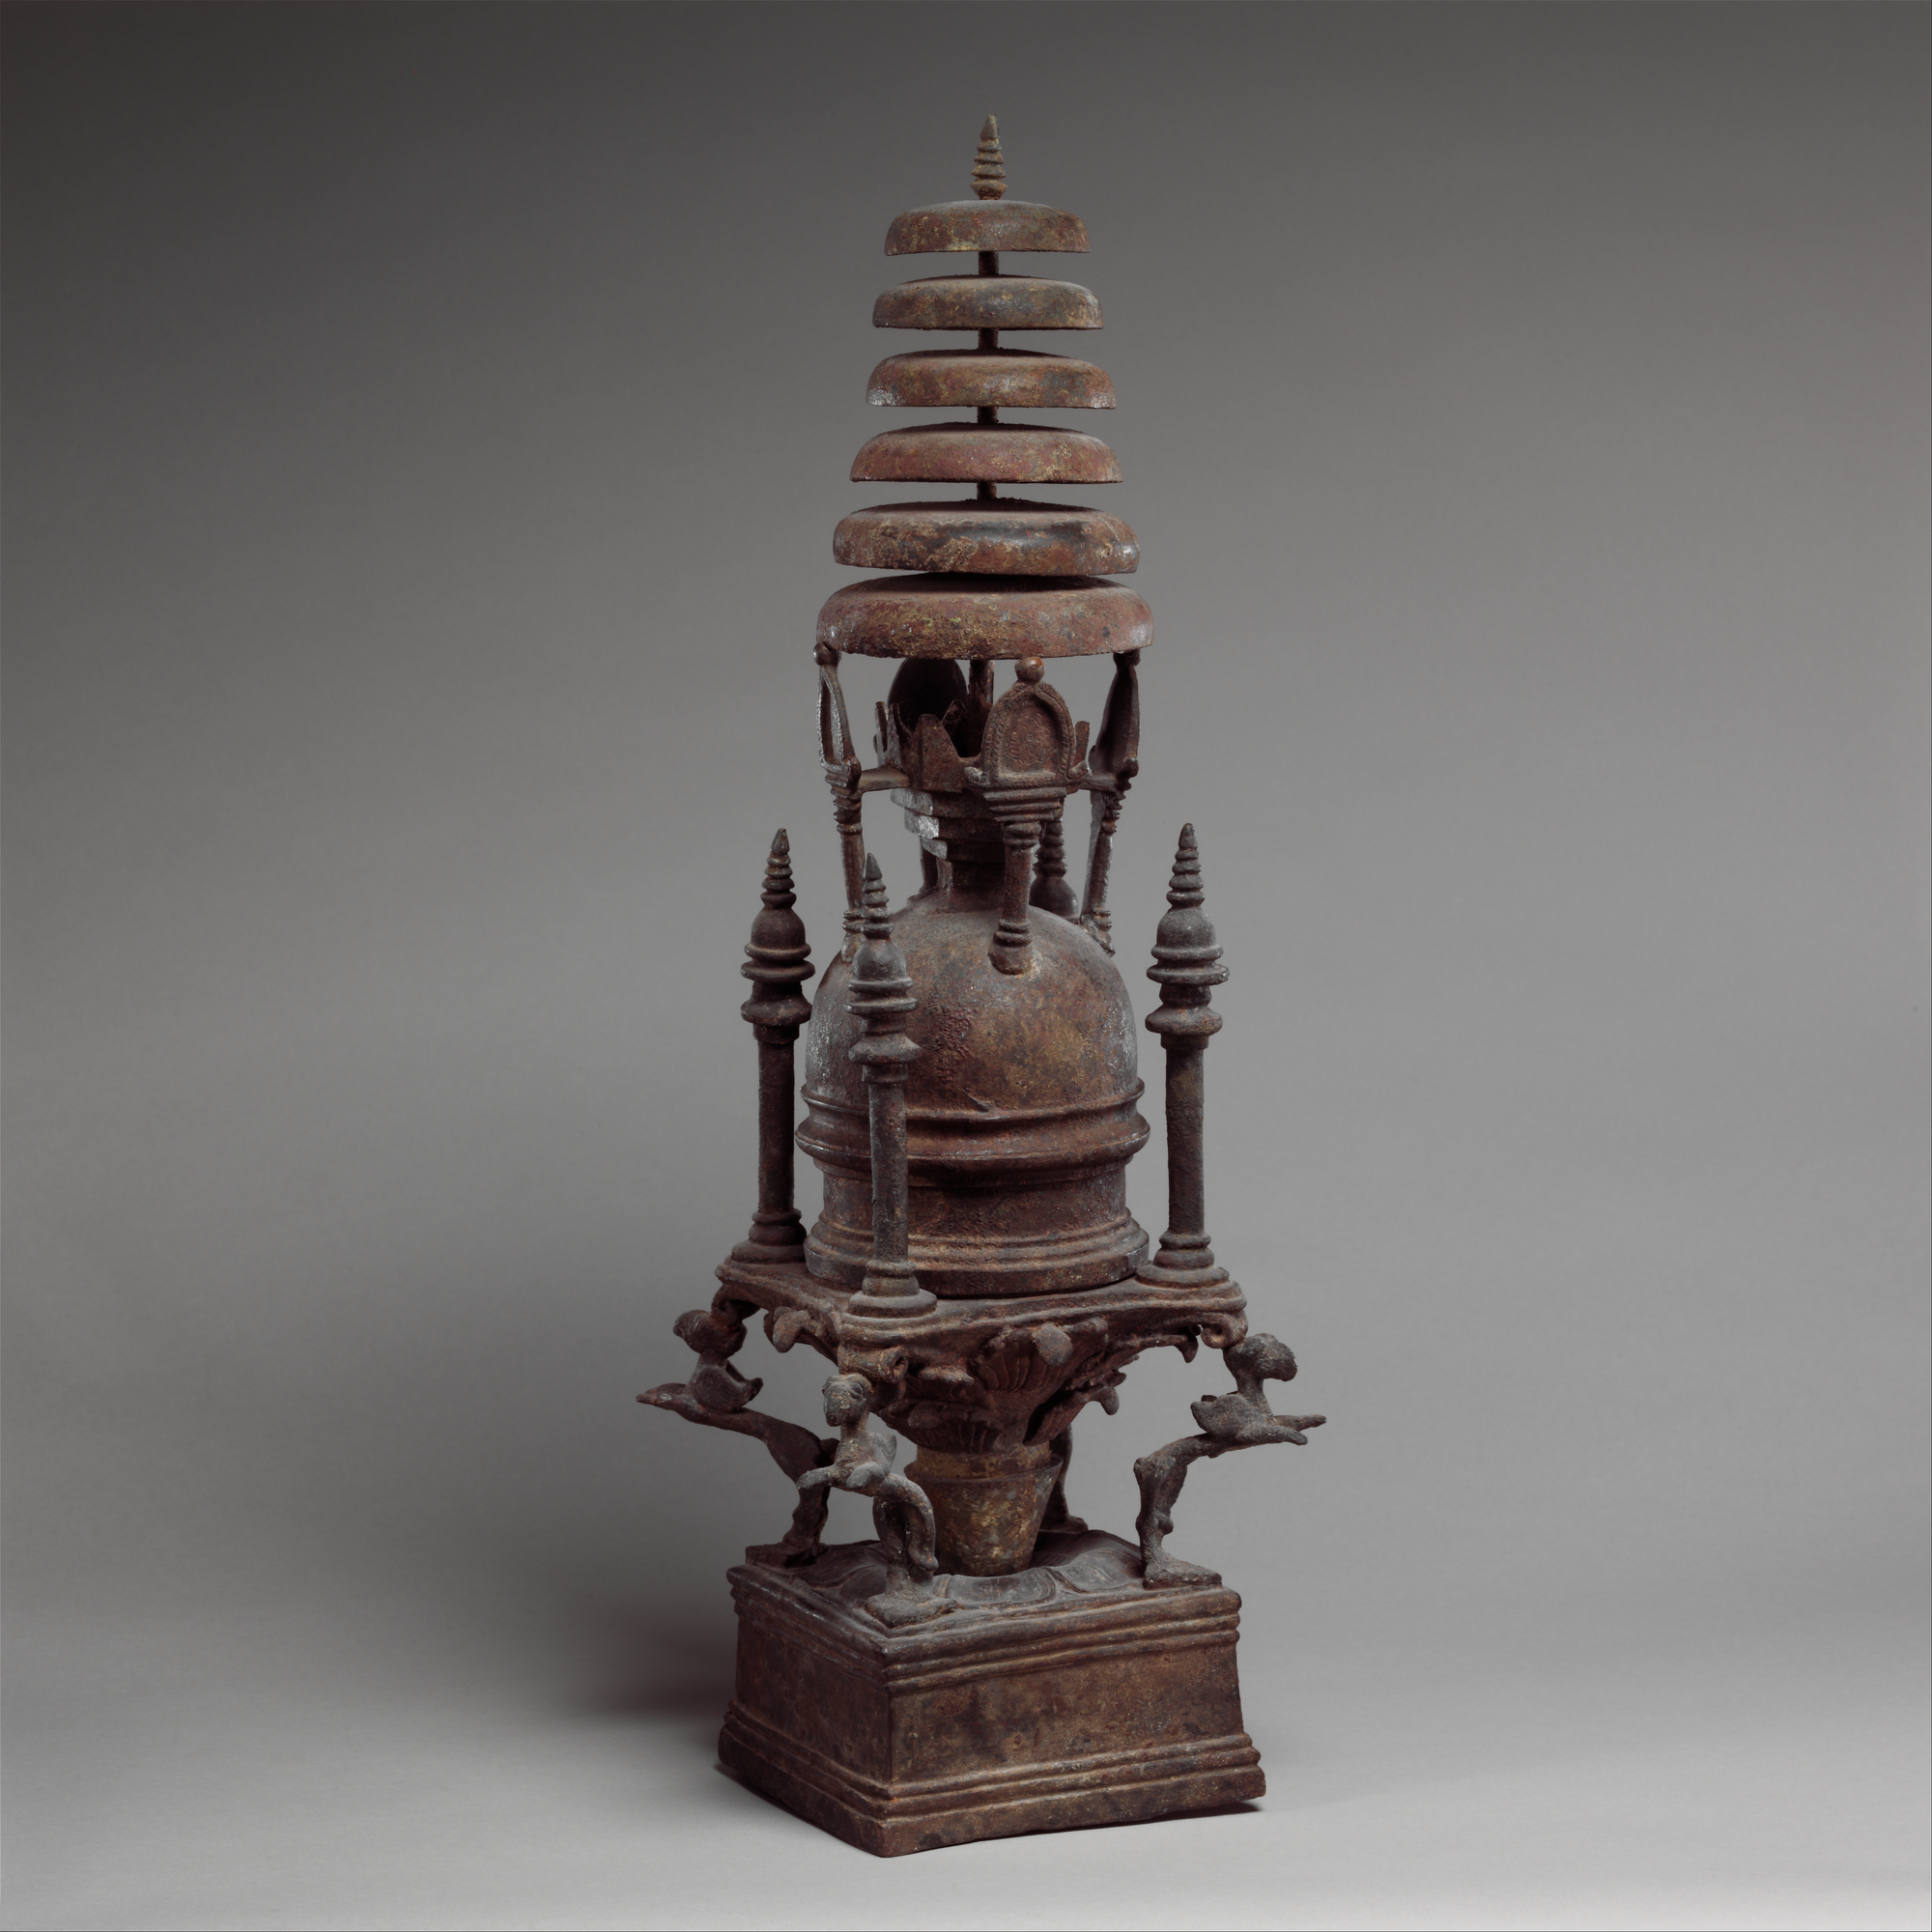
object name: reliquary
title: Reliquary in the Shape of a Stupa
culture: gandhara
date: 301-500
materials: bronze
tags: gandhara,stupas